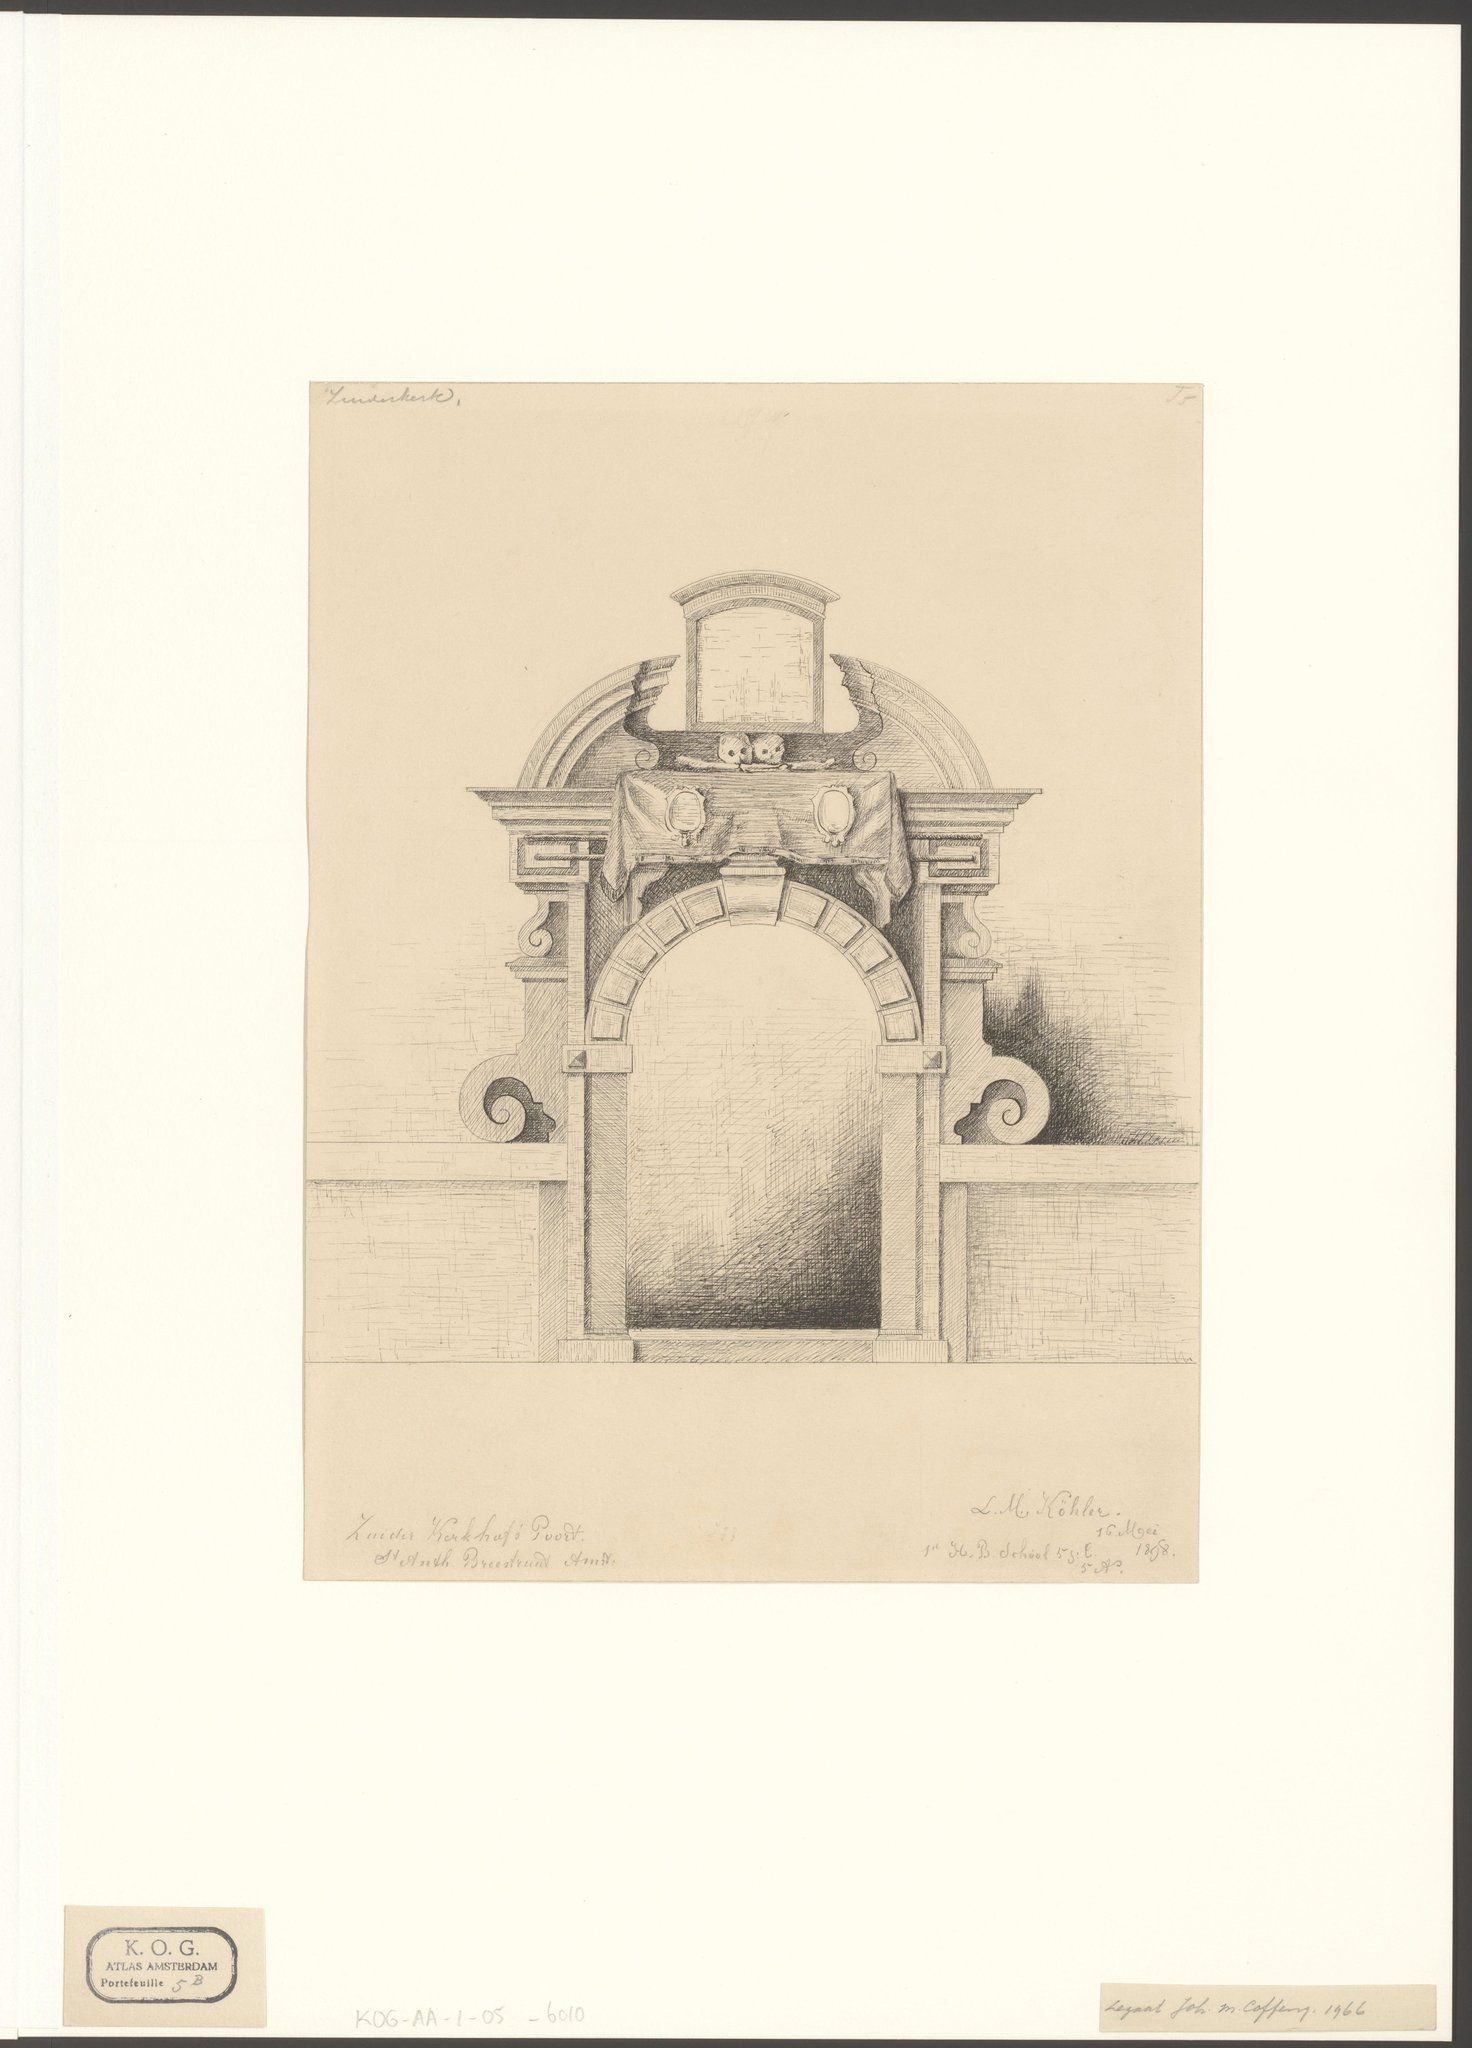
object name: drawing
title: Zuiderkerkhofpoort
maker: l.m. köhler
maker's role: draughtsman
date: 1898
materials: ink, paper, pencil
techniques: pen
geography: amsterdam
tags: city-view in general; 'veduta', gate, entrance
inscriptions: inscription: ‘Zuider Kerkhofs Poort (...) Schoof 5 [...] E / 5 [...]’, inscription: ‘Legaat Joh. M. Coffeng. 1966’, signature and date: ‘L.M. Köhler. / 16 Mei 1898.’, collector's mark: ‘5B’ Lugt 1641b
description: Onderwerpsrubriek binnen de Atlas Amsterdam: Amstelgrachtje, Amstelkanaal (Noorder-), Amstelveld, Amstelstraat (Nieuwe), Annadwarsstraat, Antoniebreestraat.